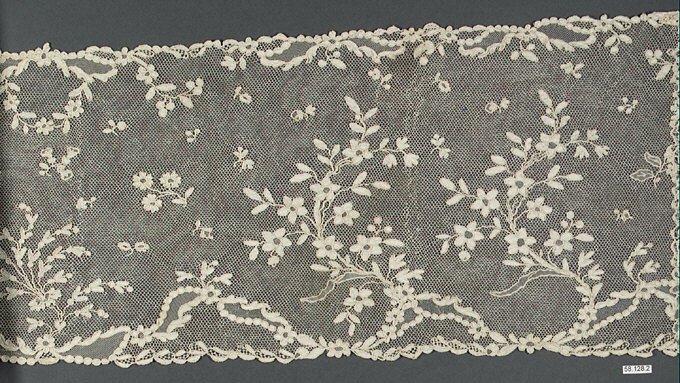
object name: scarf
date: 1801-1900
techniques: lace